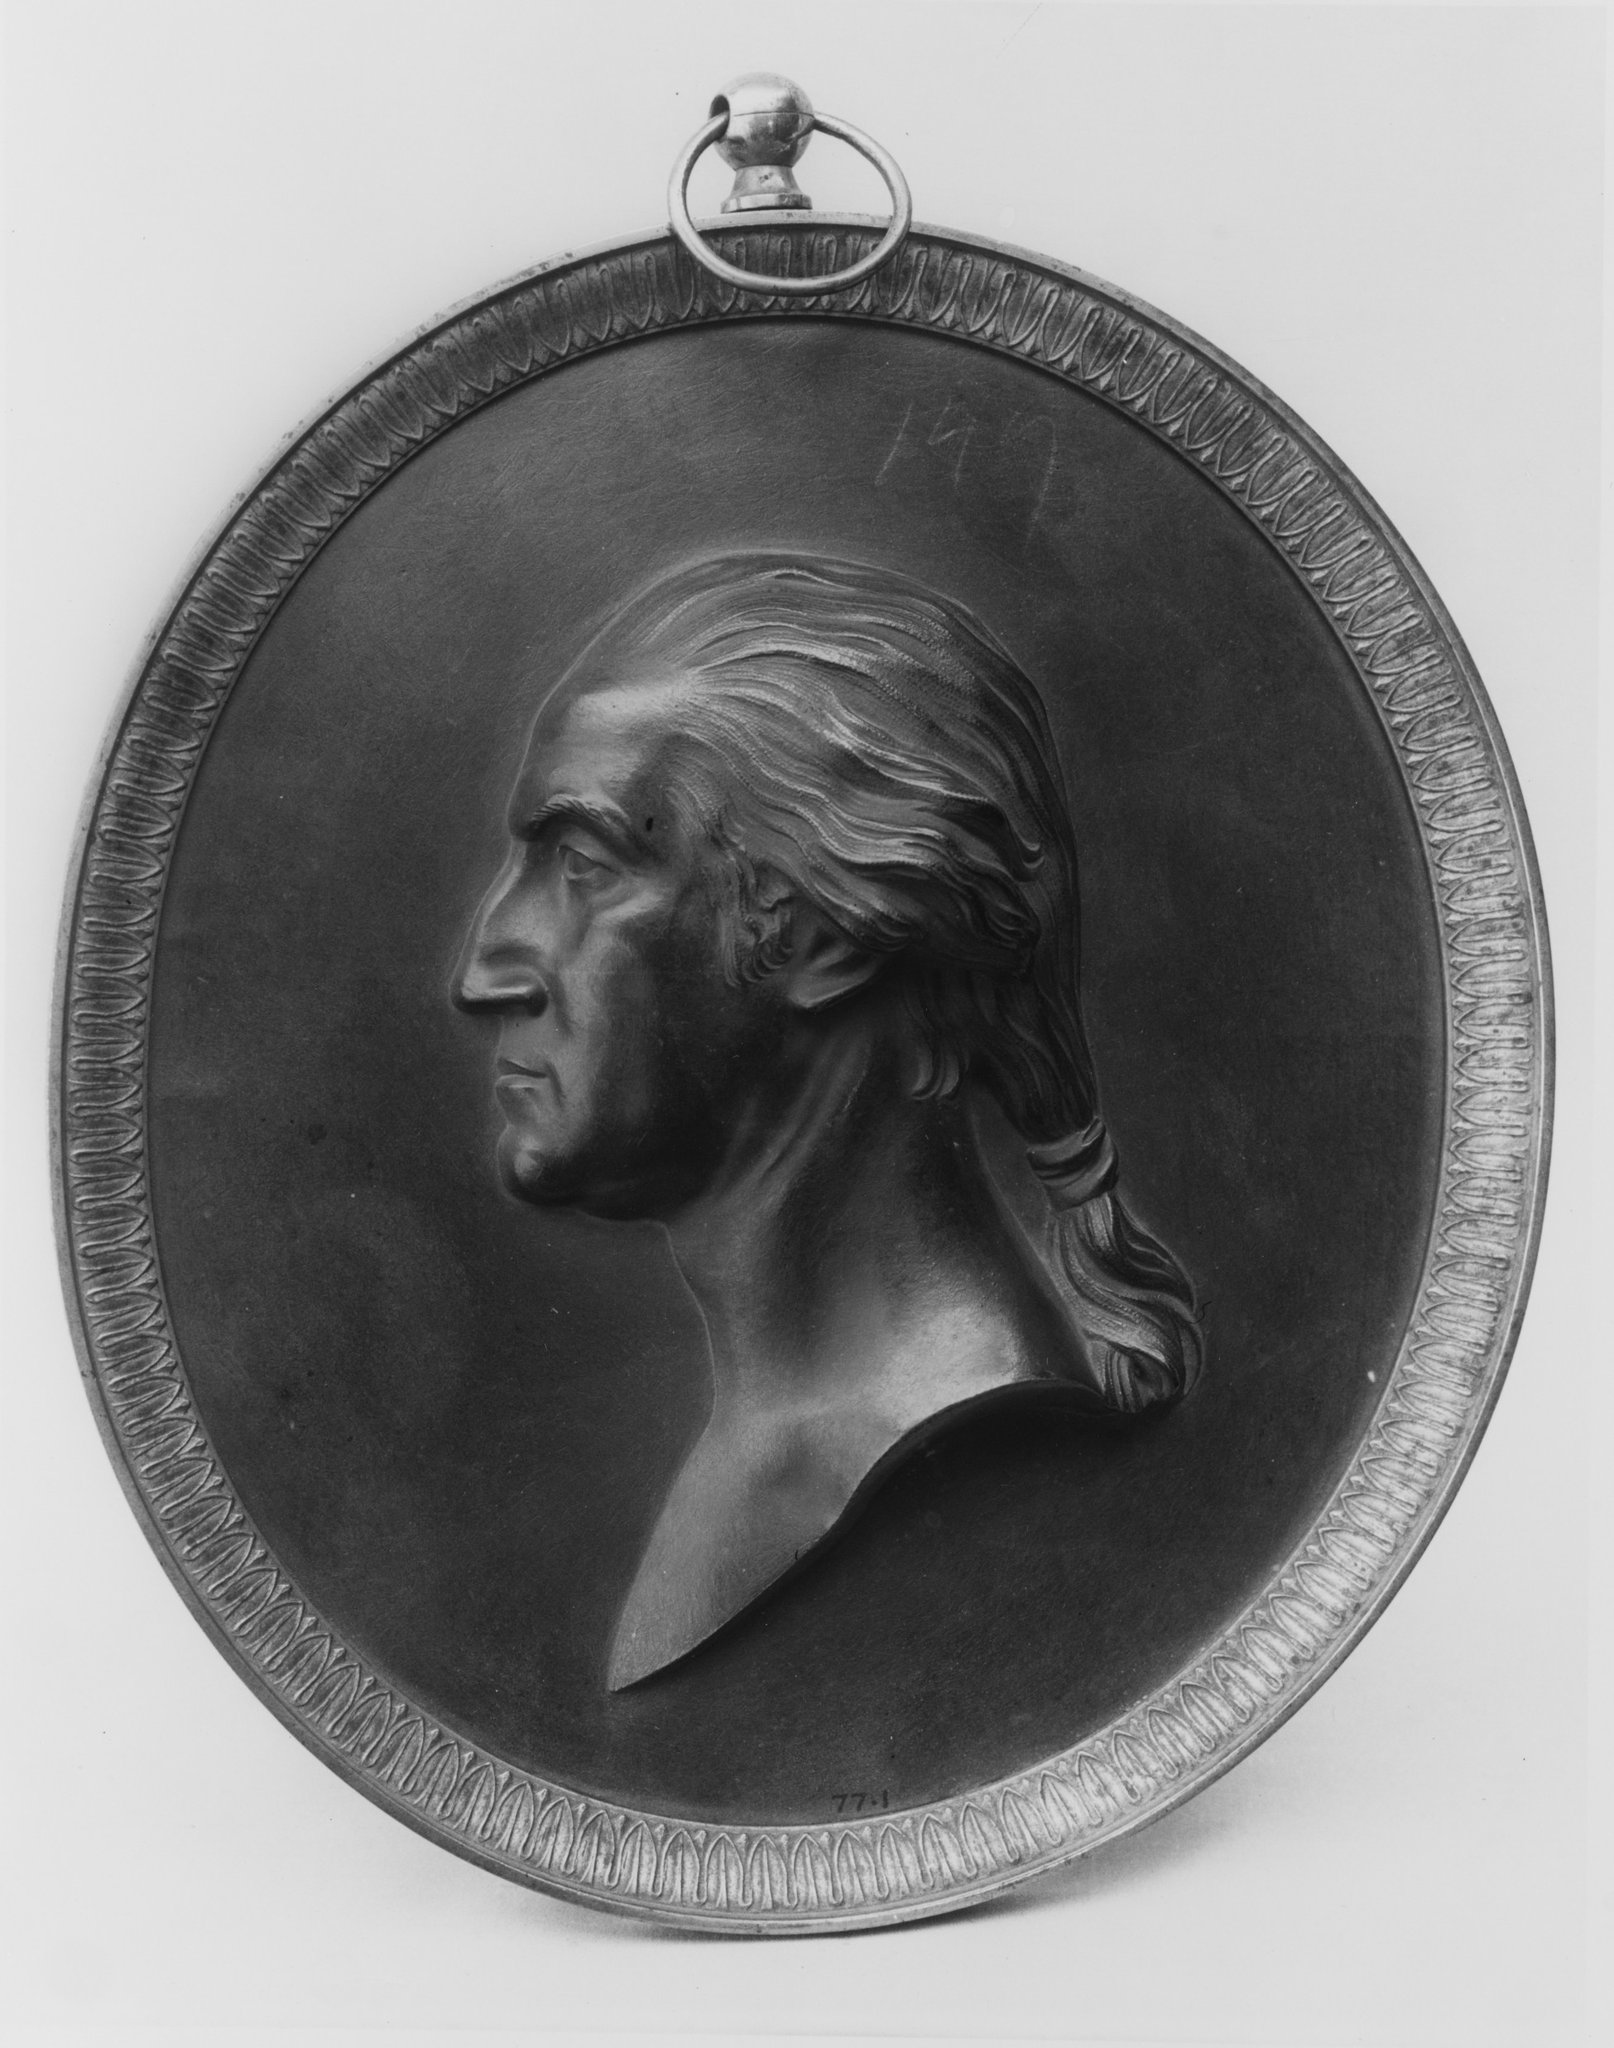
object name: medallion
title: George Washington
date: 1800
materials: brass, bronze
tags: george washington,portraits,profiles